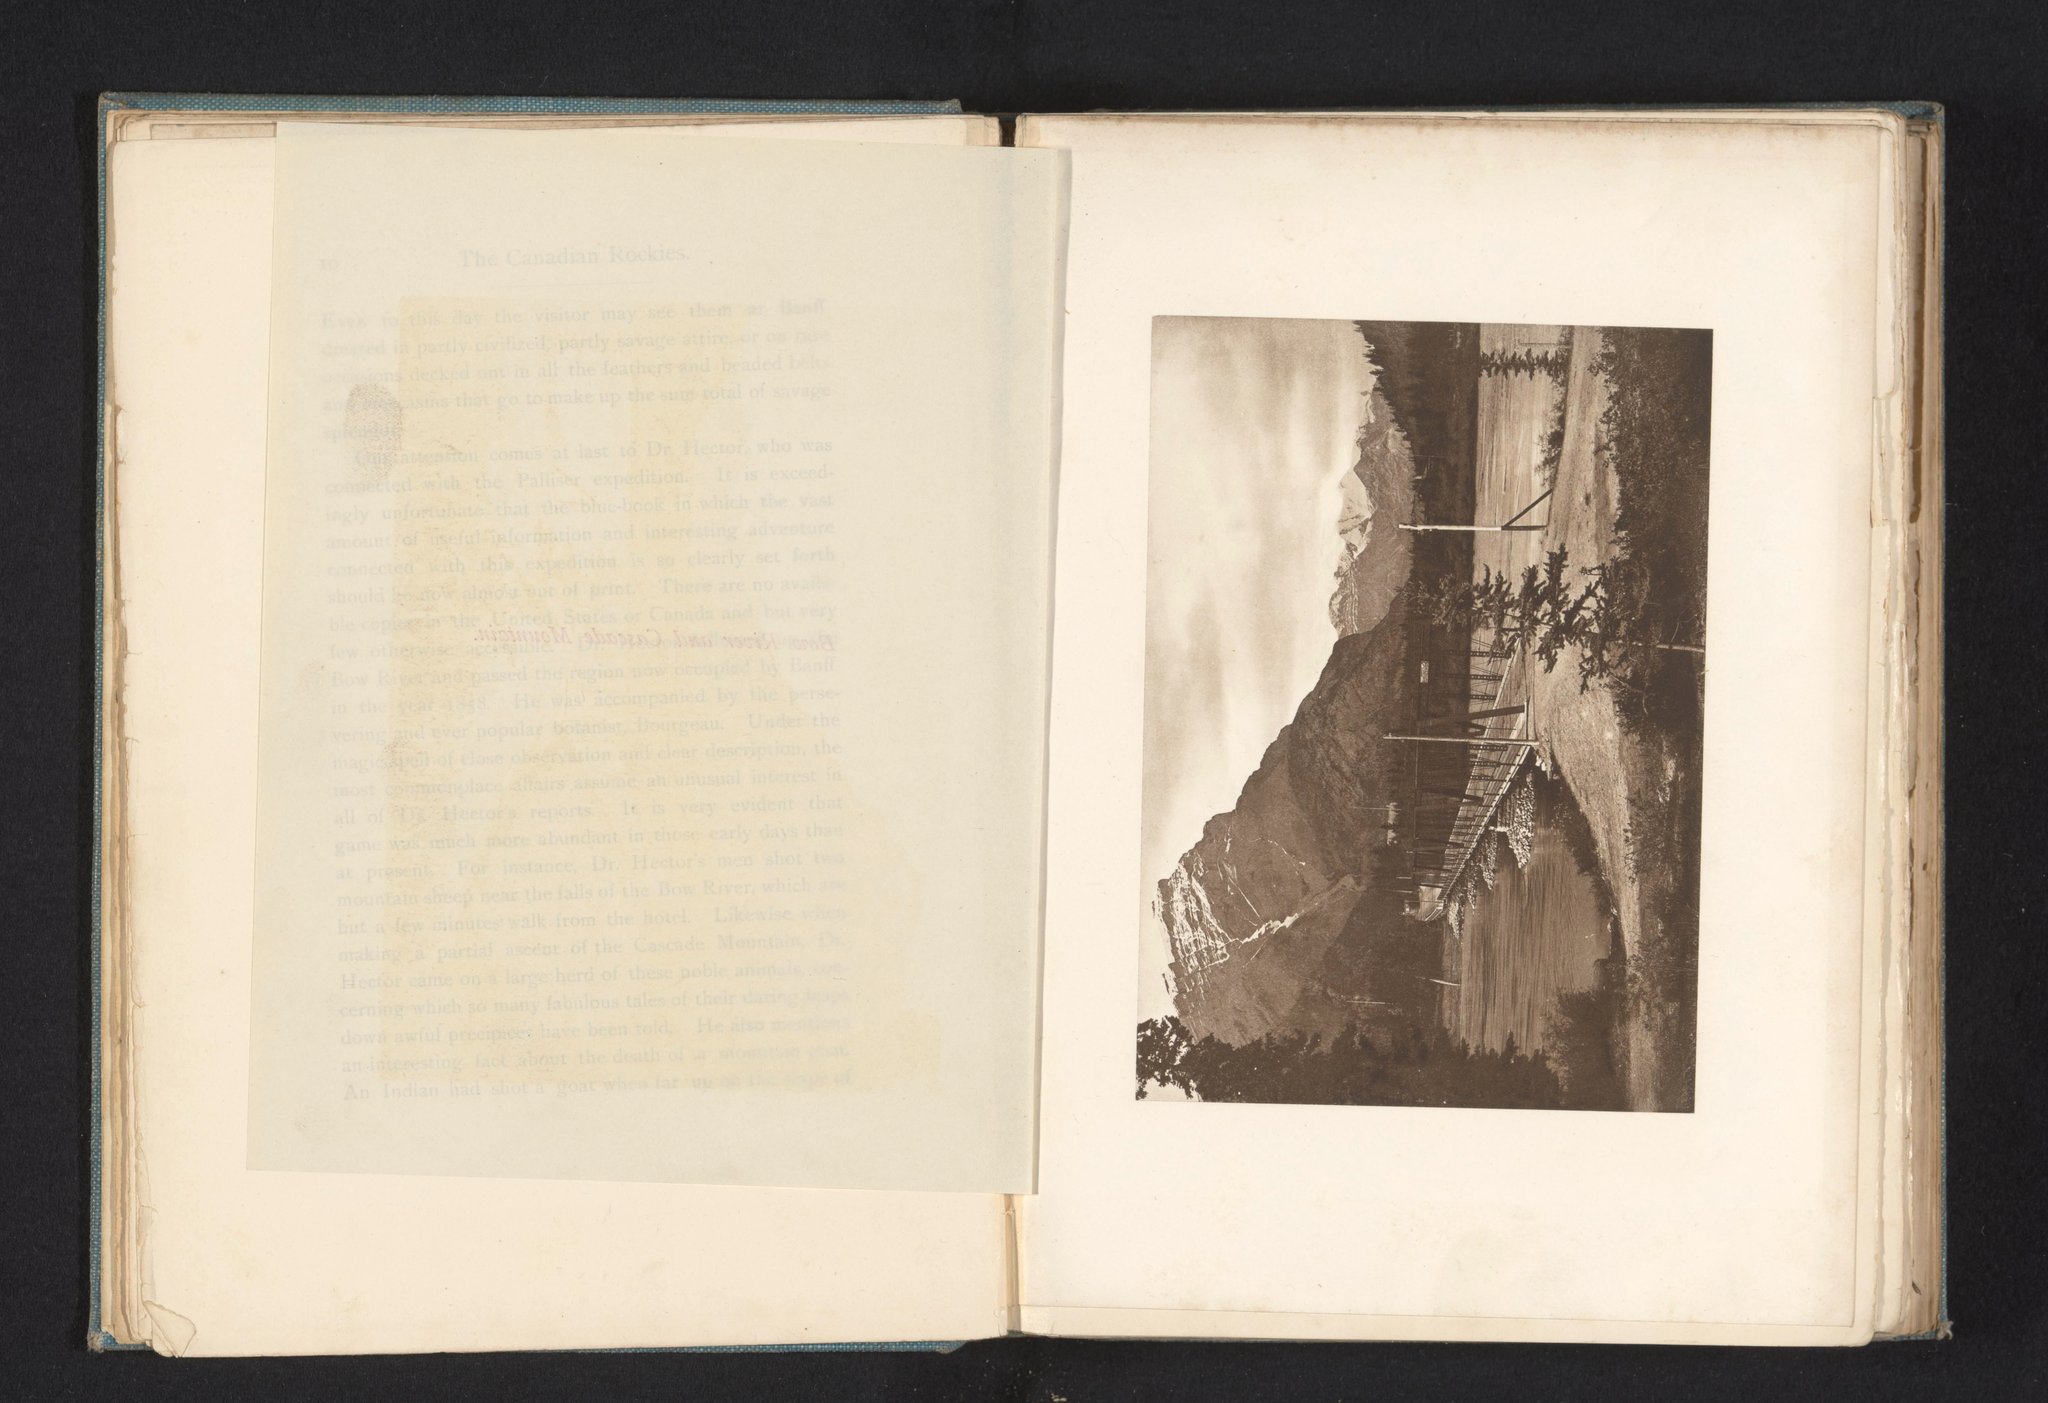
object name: photomechanical print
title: Brug over de Bow, met op de achtergrond Cascade Mountain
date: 1893-1897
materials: paper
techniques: photoaquatint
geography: alberta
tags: bridge in city across river, canal, etc., mountains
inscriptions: title: ‘Bow River and Cascade Mountain’